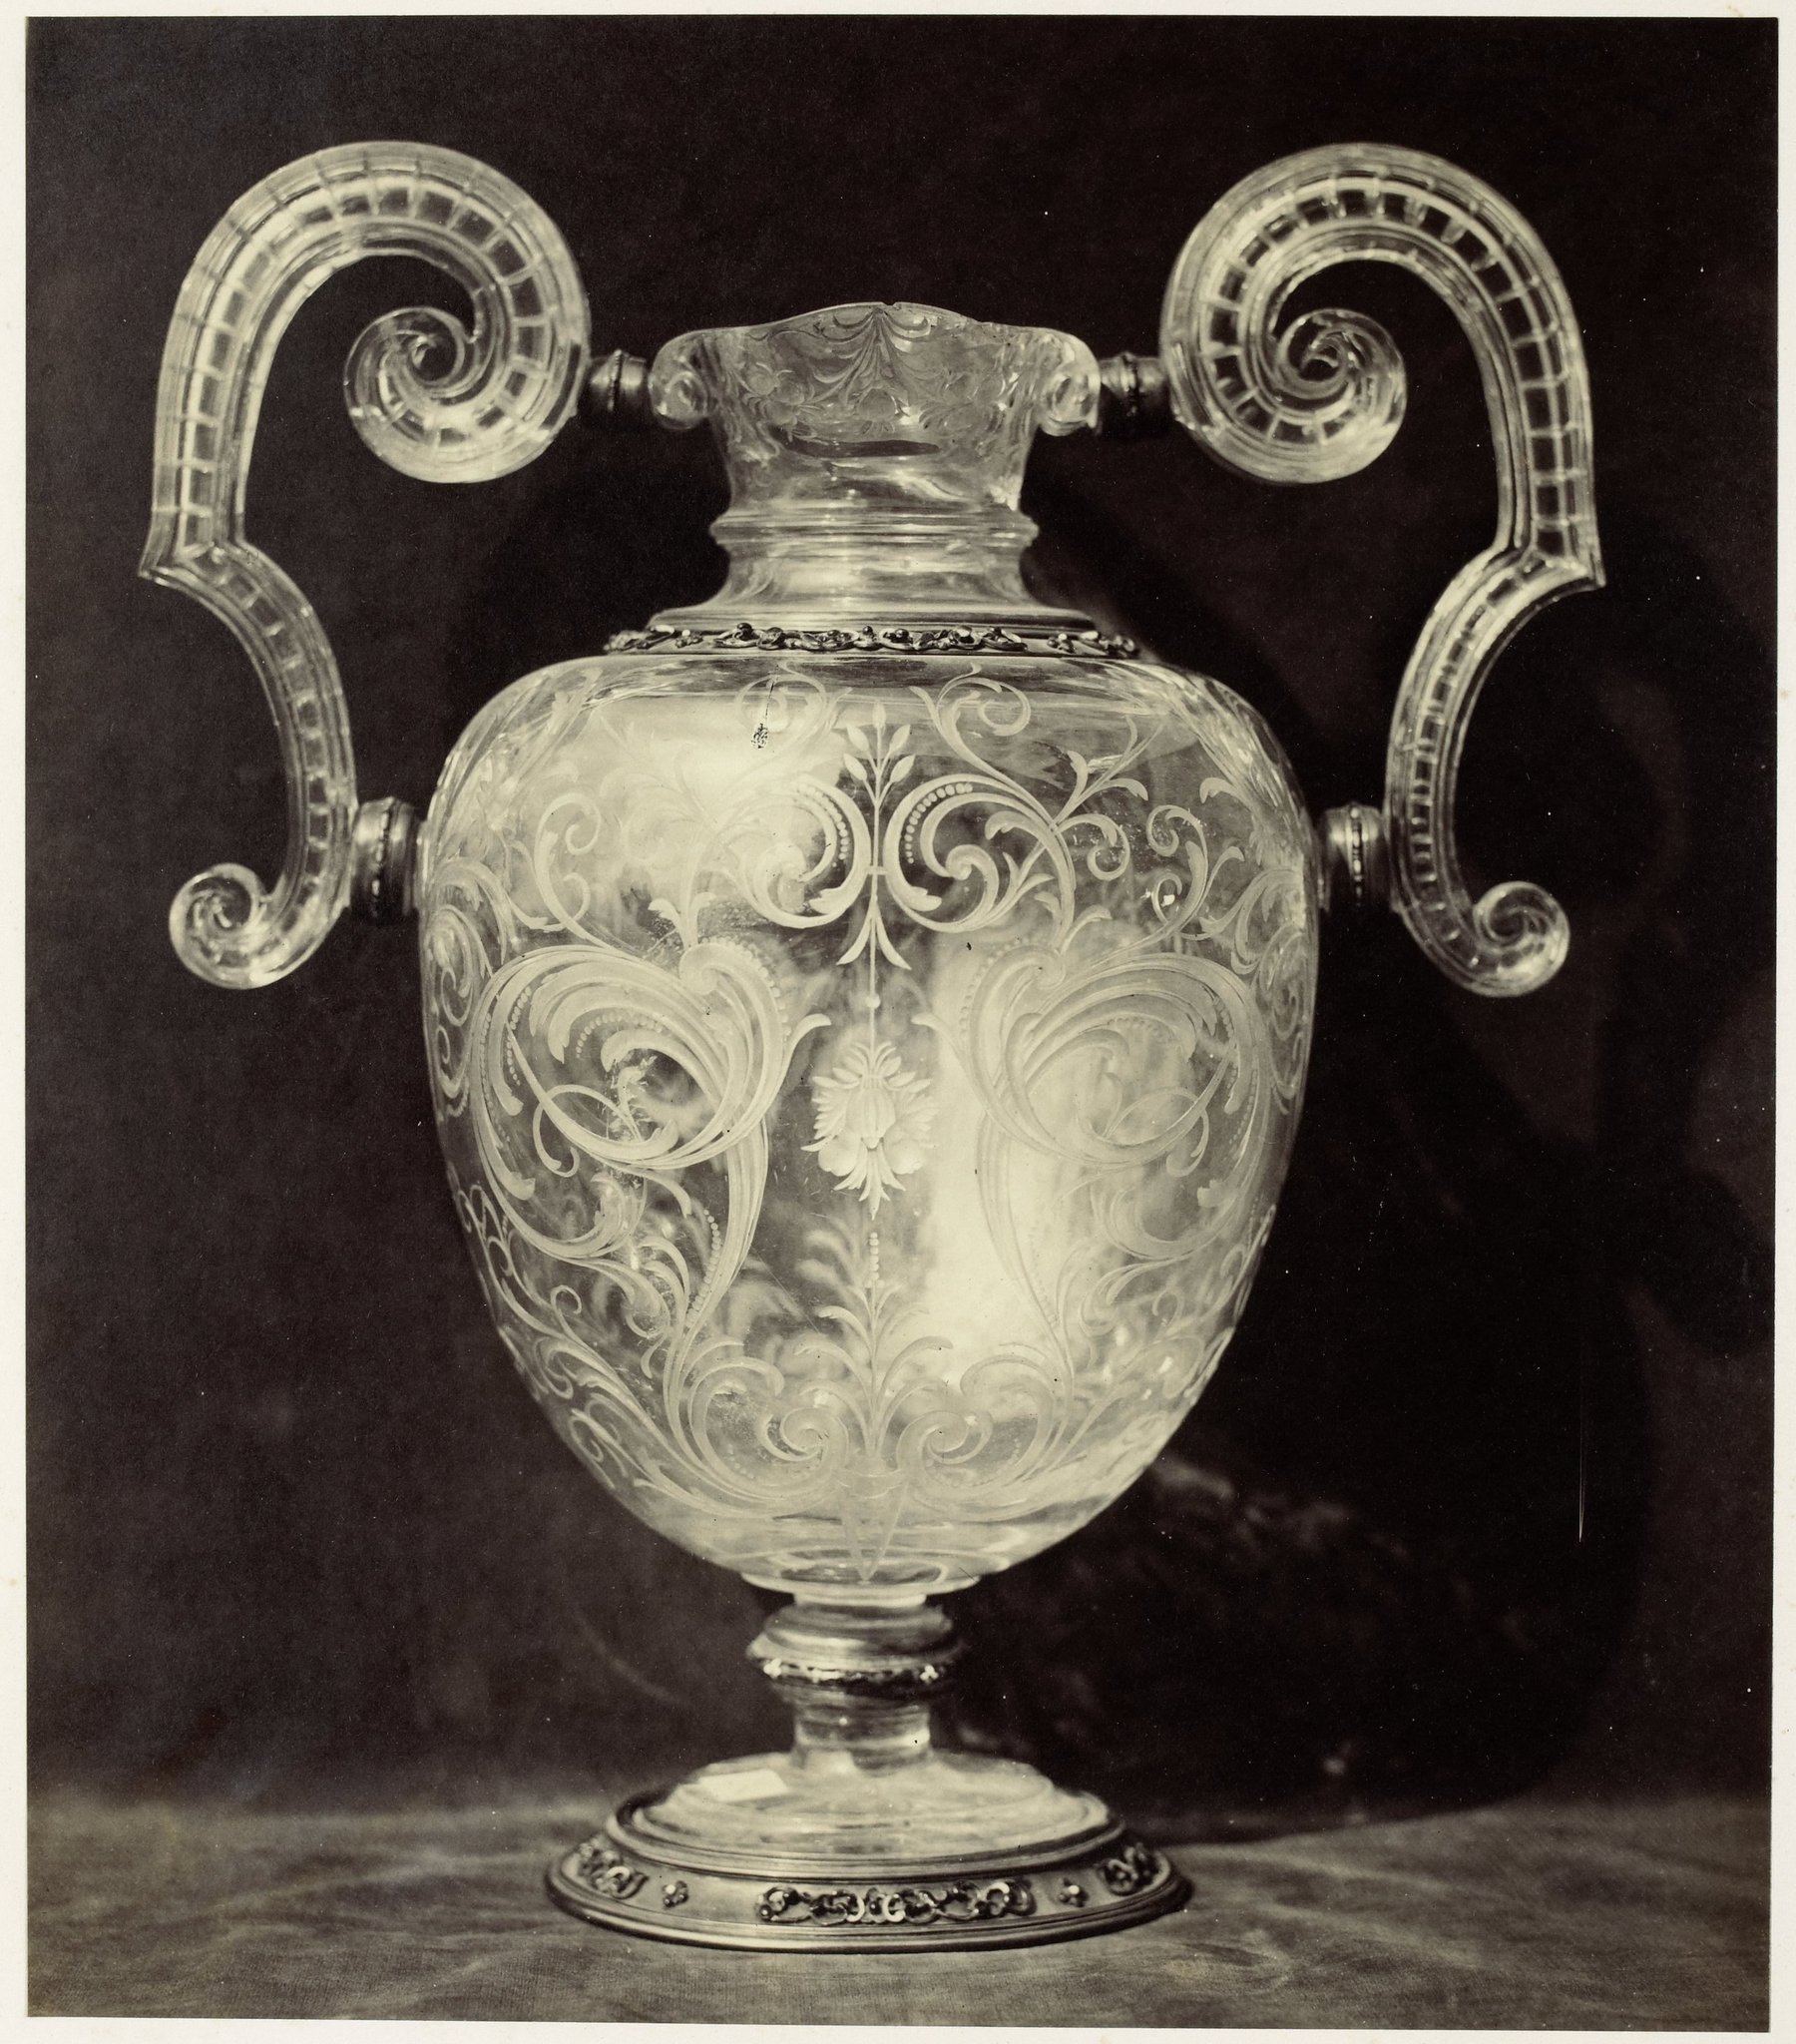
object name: photomechanical print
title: Gegraveerde kristallen volutenkan, uit het Louvre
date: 1866-1890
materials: paper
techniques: woodburytype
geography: louvre museum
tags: container of glass: bottle, jar, vase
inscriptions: inscription: ‘Photographed by C. Thurston Thompson.’